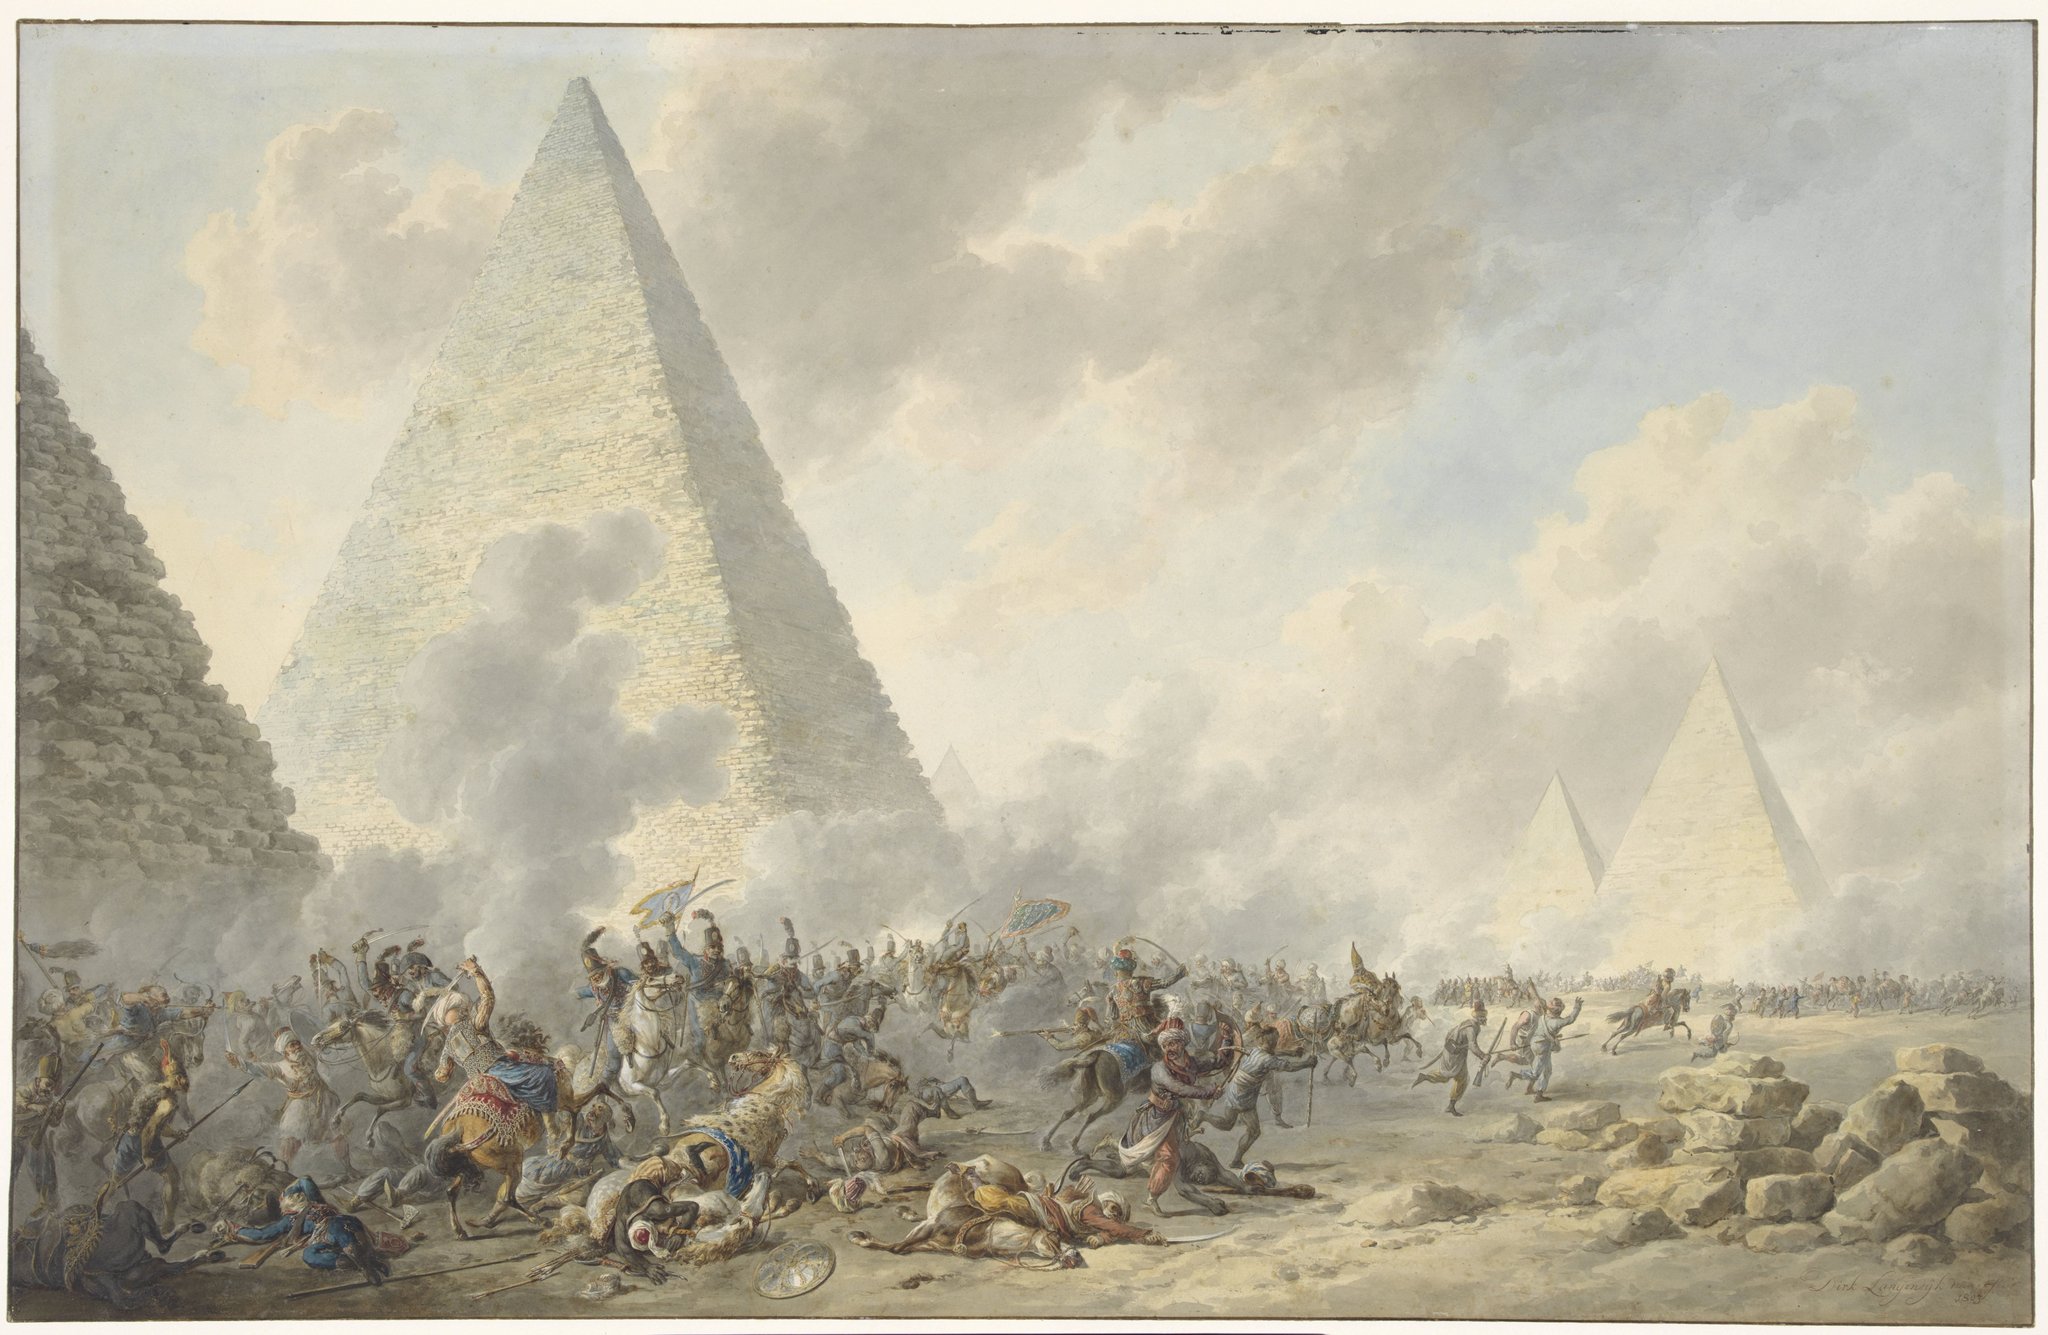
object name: drawing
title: Battle of the Pyramids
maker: dirk langendijk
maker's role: draughtsman, painter, print maker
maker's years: 1748-1805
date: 1803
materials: ink, paper, pencil, watercolor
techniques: brush, pen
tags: pyramid (historical grave form), battle (+ land forces), historical events and situations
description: Dirk Langendijk was a prolific draughtsman specializing in military scenes with numerous small figures. His style was appropriately pithy. Yet although several military encounters took place in the Netherlands during the Revolutionary period of 1789–1799, he based most of his depictions on his own imagination. It was at the Battle of the Pyramids in 1798 that Napoleon’s French army defeated the Egyptian Mamluks.